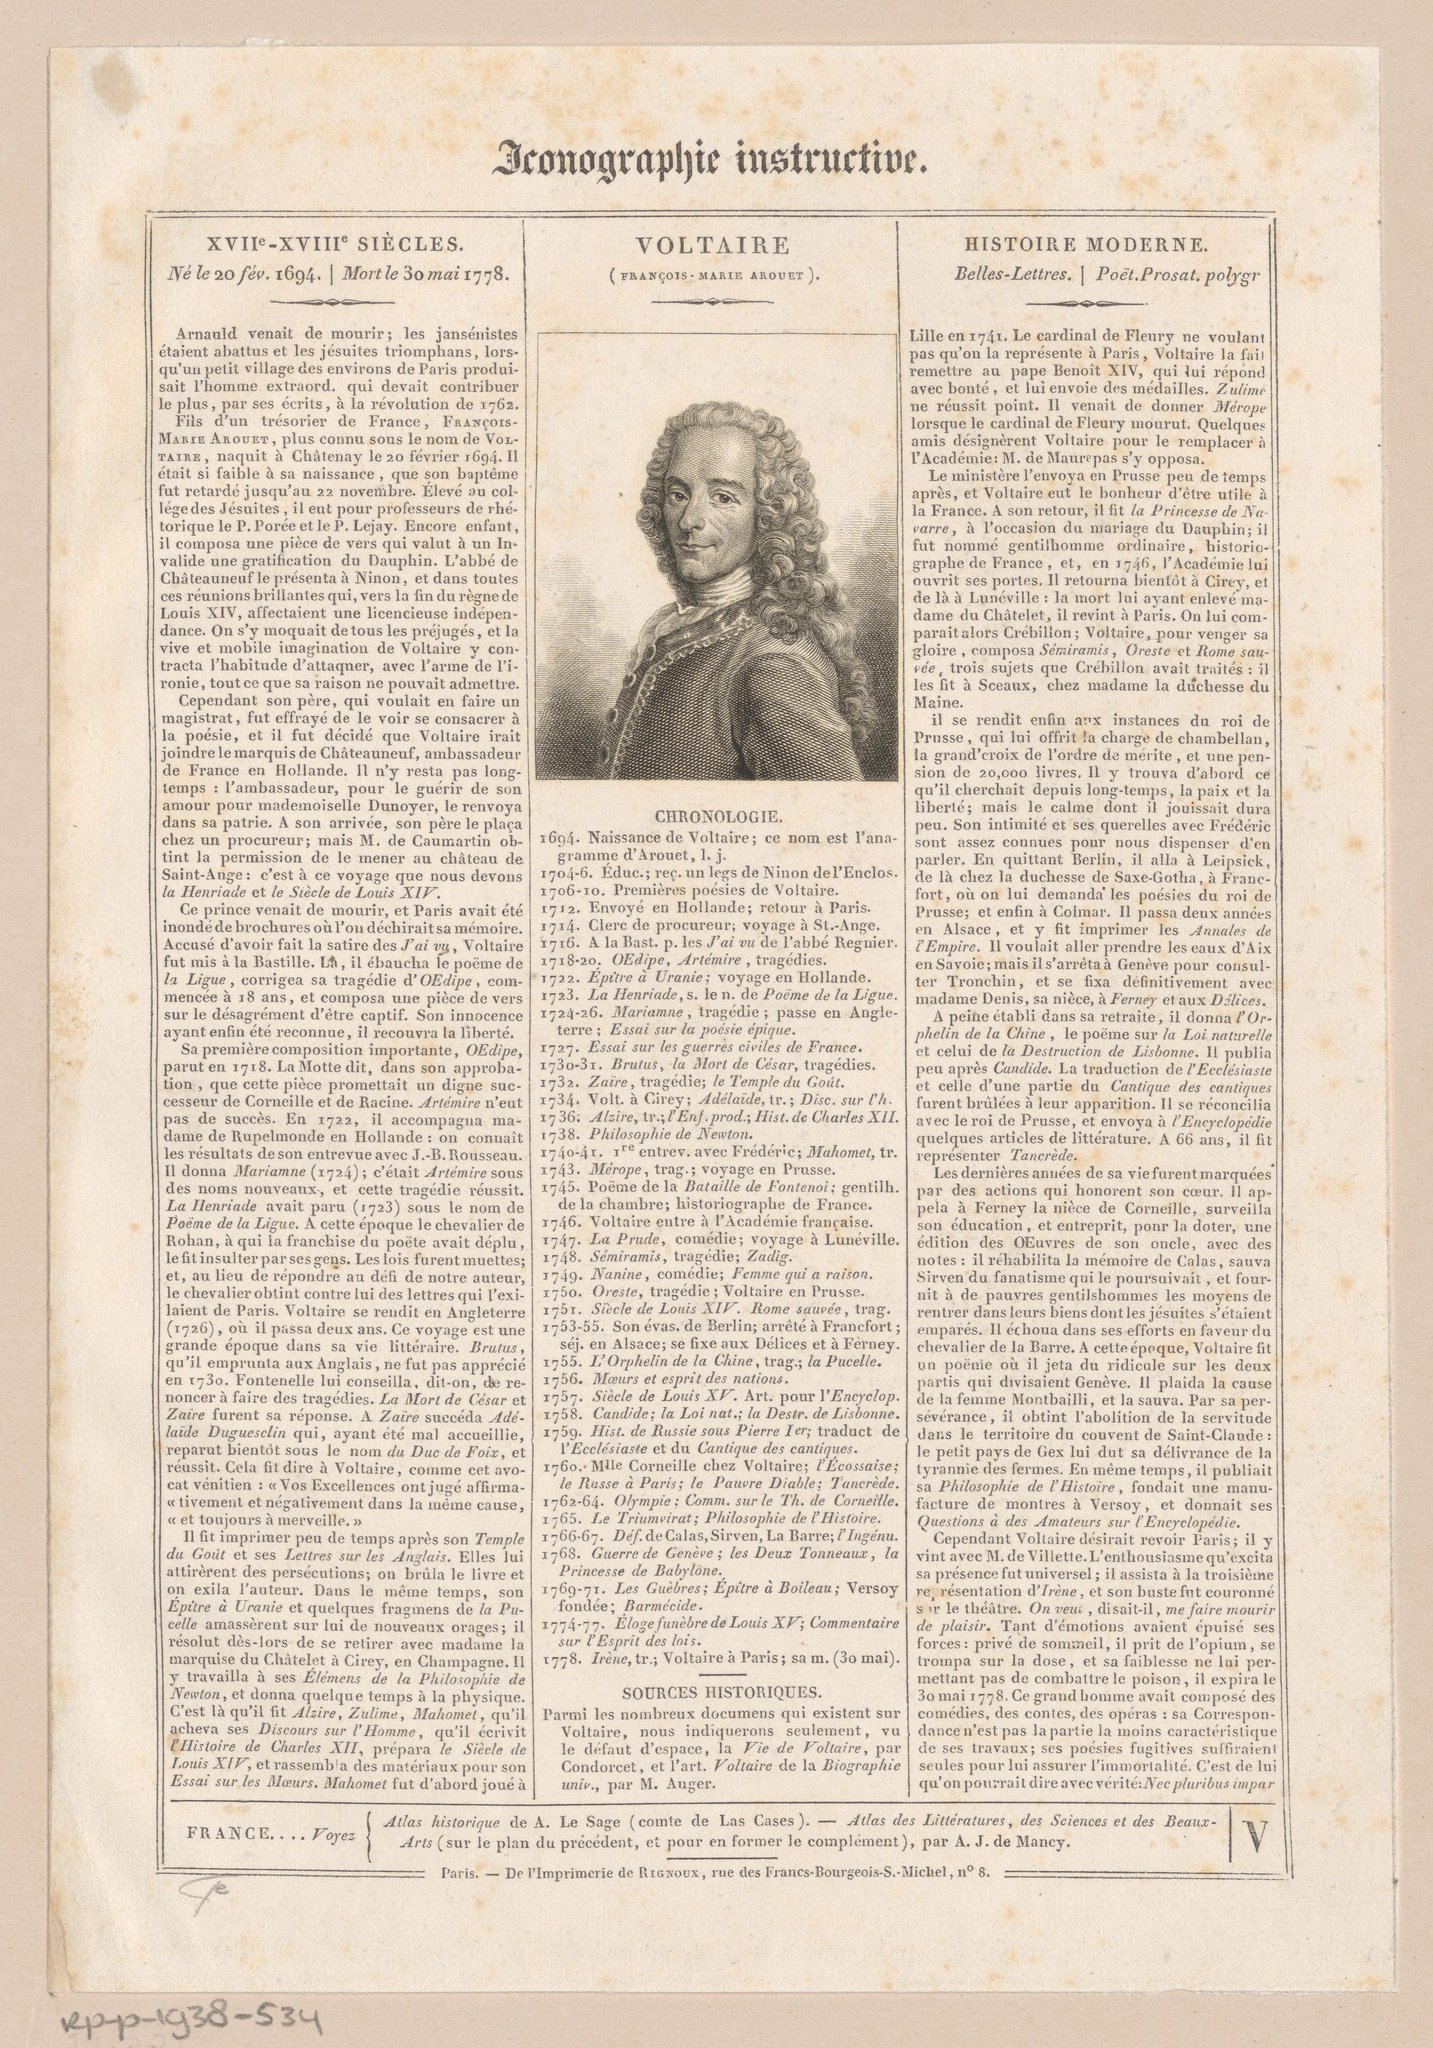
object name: print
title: Portret van Voltaire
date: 1839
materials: paper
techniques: etching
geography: france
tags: paris, voltaire, historical persons, portrait of a writer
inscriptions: collector's mark: Lugt 2228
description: Prent uit: Fliniaux, A. Galerie historique, collection de 200 portraits des personnages (...). Parijs: Jean François Bènard, 1839.